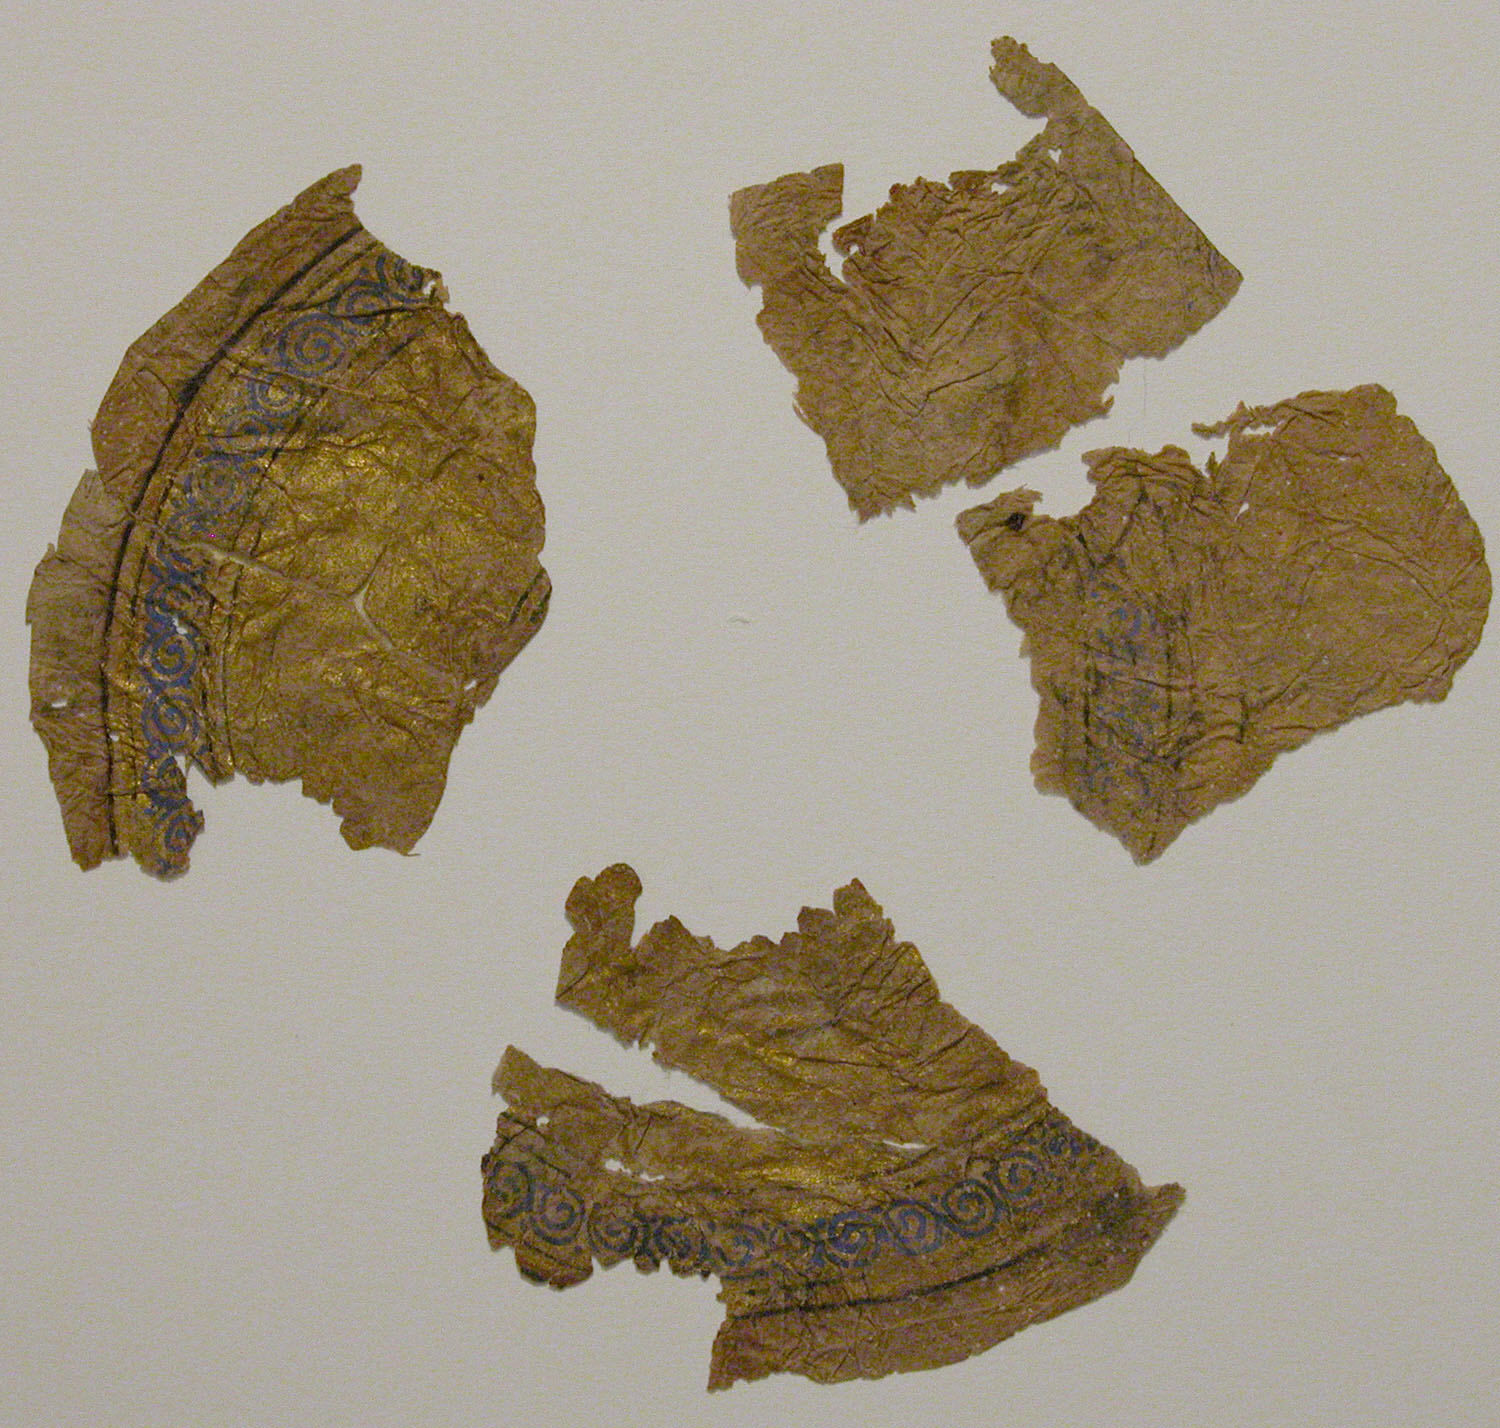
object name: fragment of a non illustrated single work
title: Fragments of a Non-Illustrated Single Work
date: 1201-1300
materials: gold, ink, paper, watercolor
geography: egypt